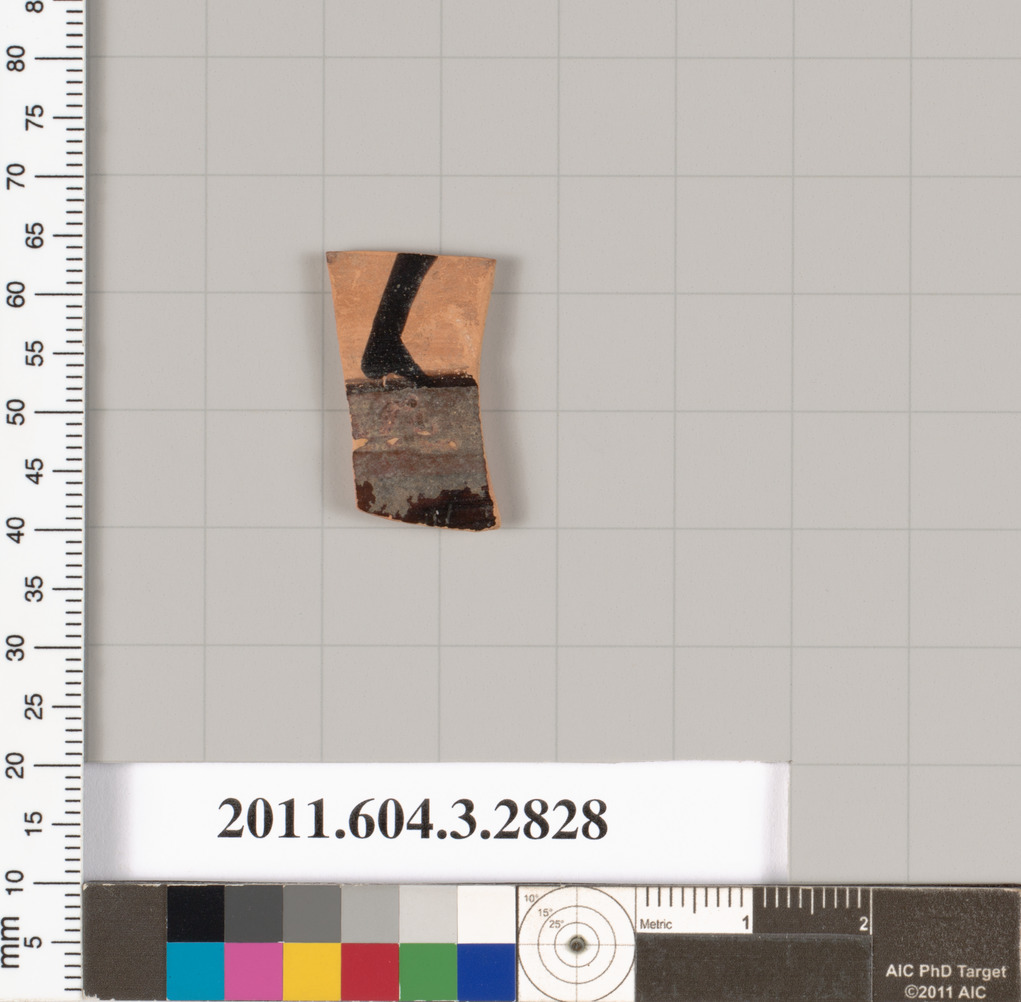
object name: oinochoe or olpe fragment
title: Terracotta fragment of an oinochoe (jug) or an olpe (jug)?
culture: greek, attic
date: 534-468 BCE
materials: terracotta